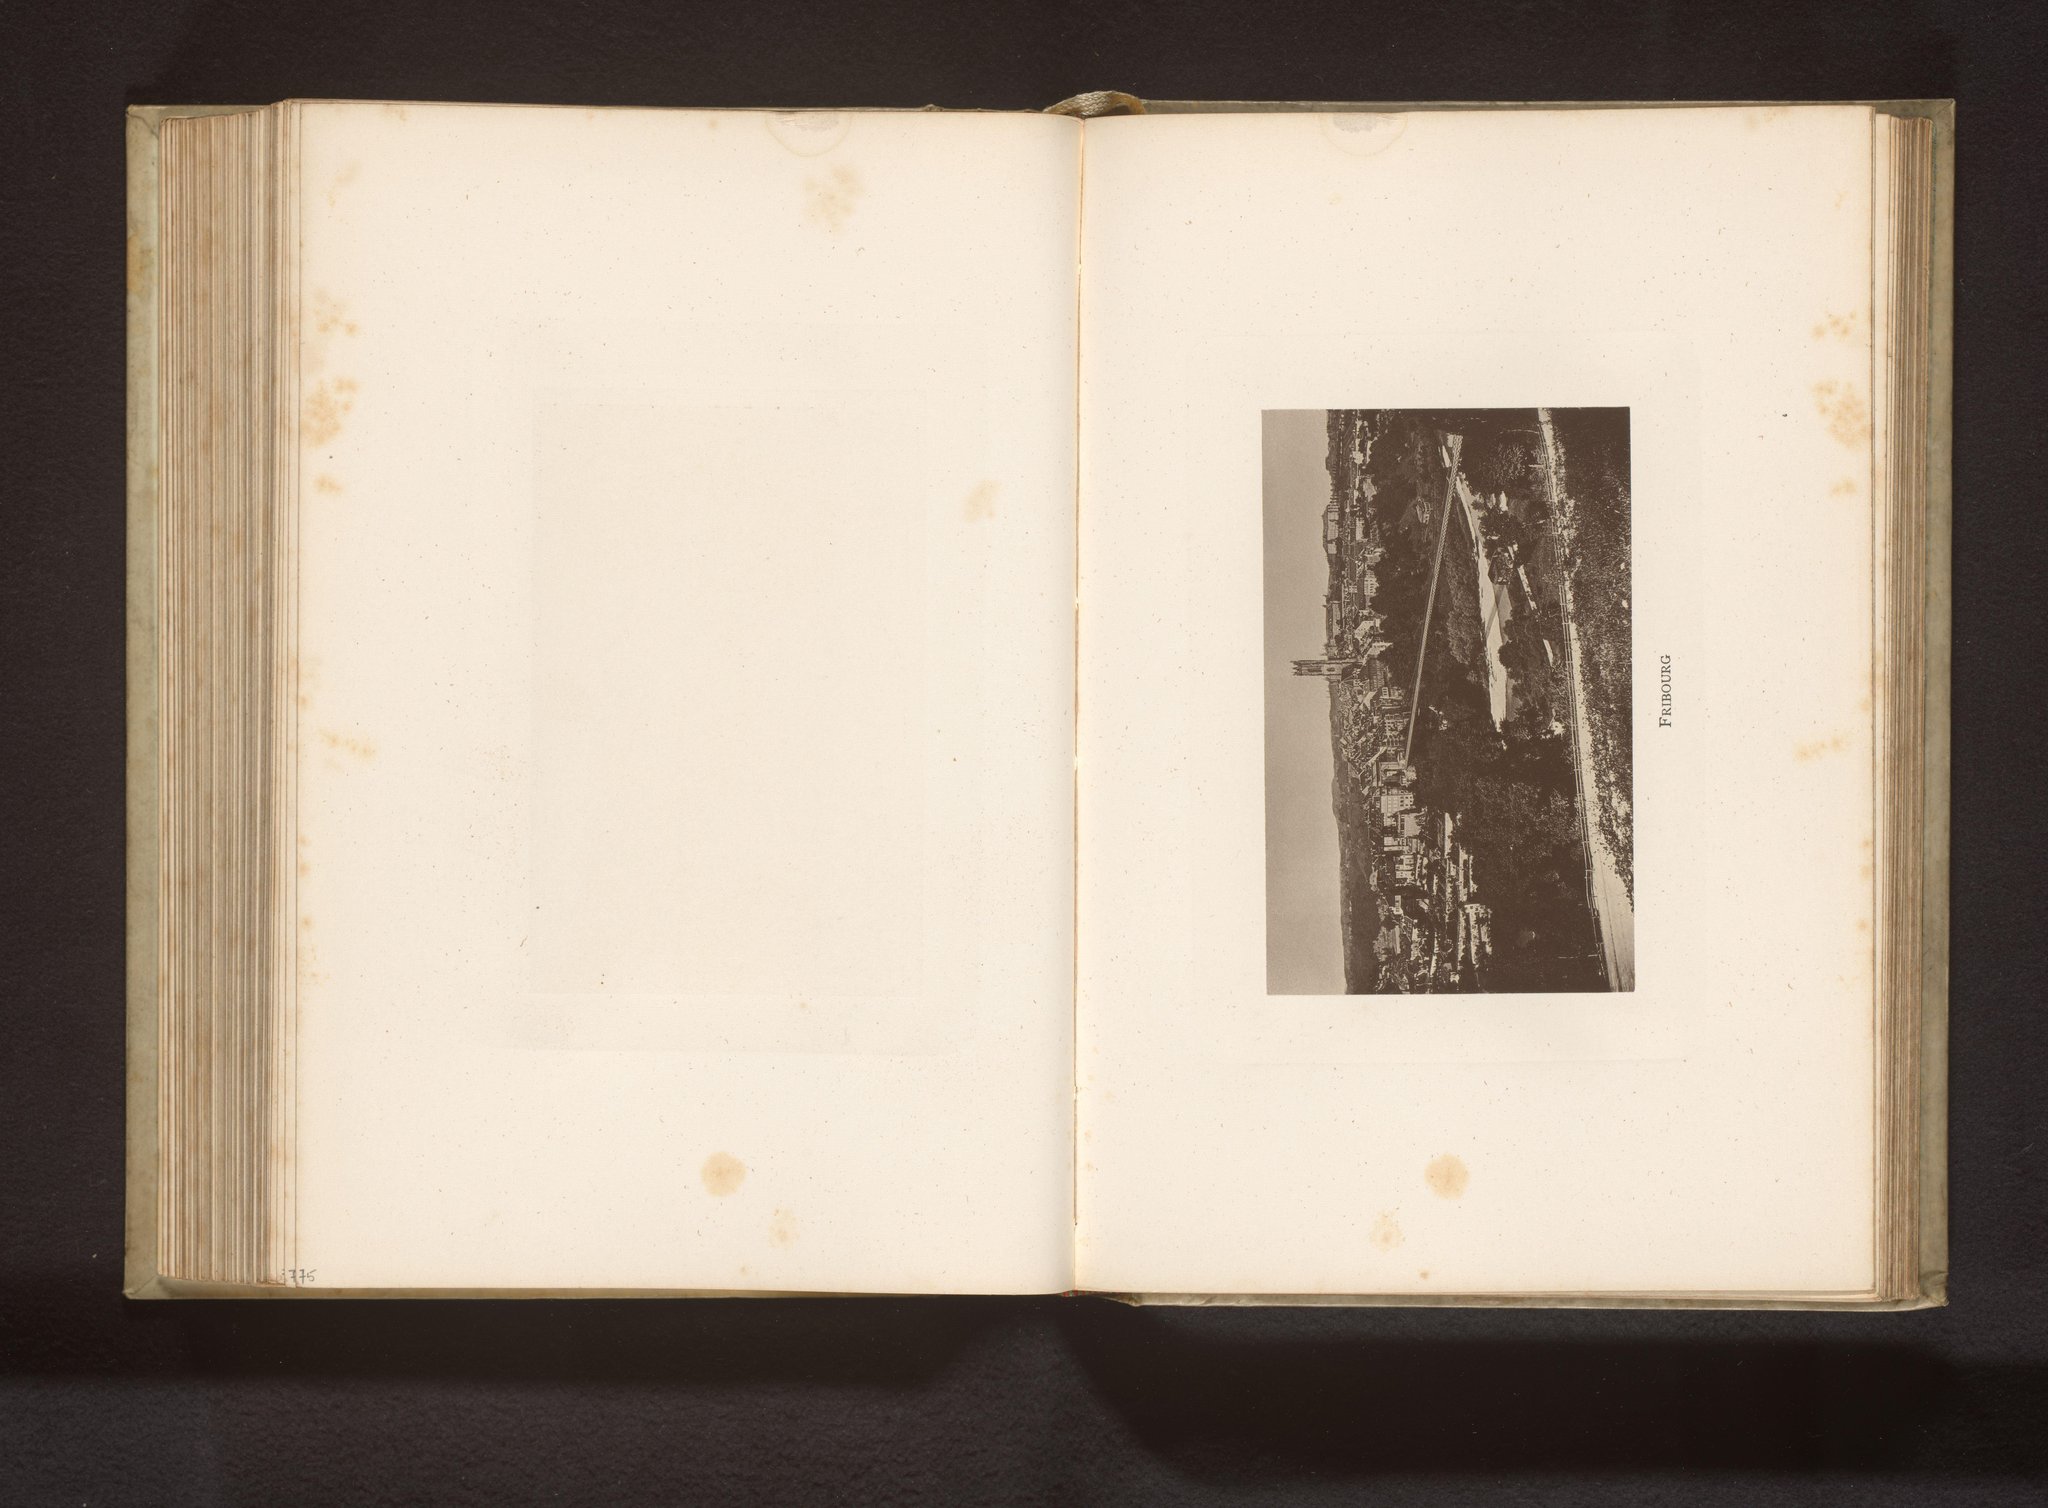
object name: photomechanical print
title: Fribourg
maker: Anonymous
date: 1874-1884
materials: paper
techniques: photograph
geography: fribourg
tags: city-view, and landscape with man-made constructions